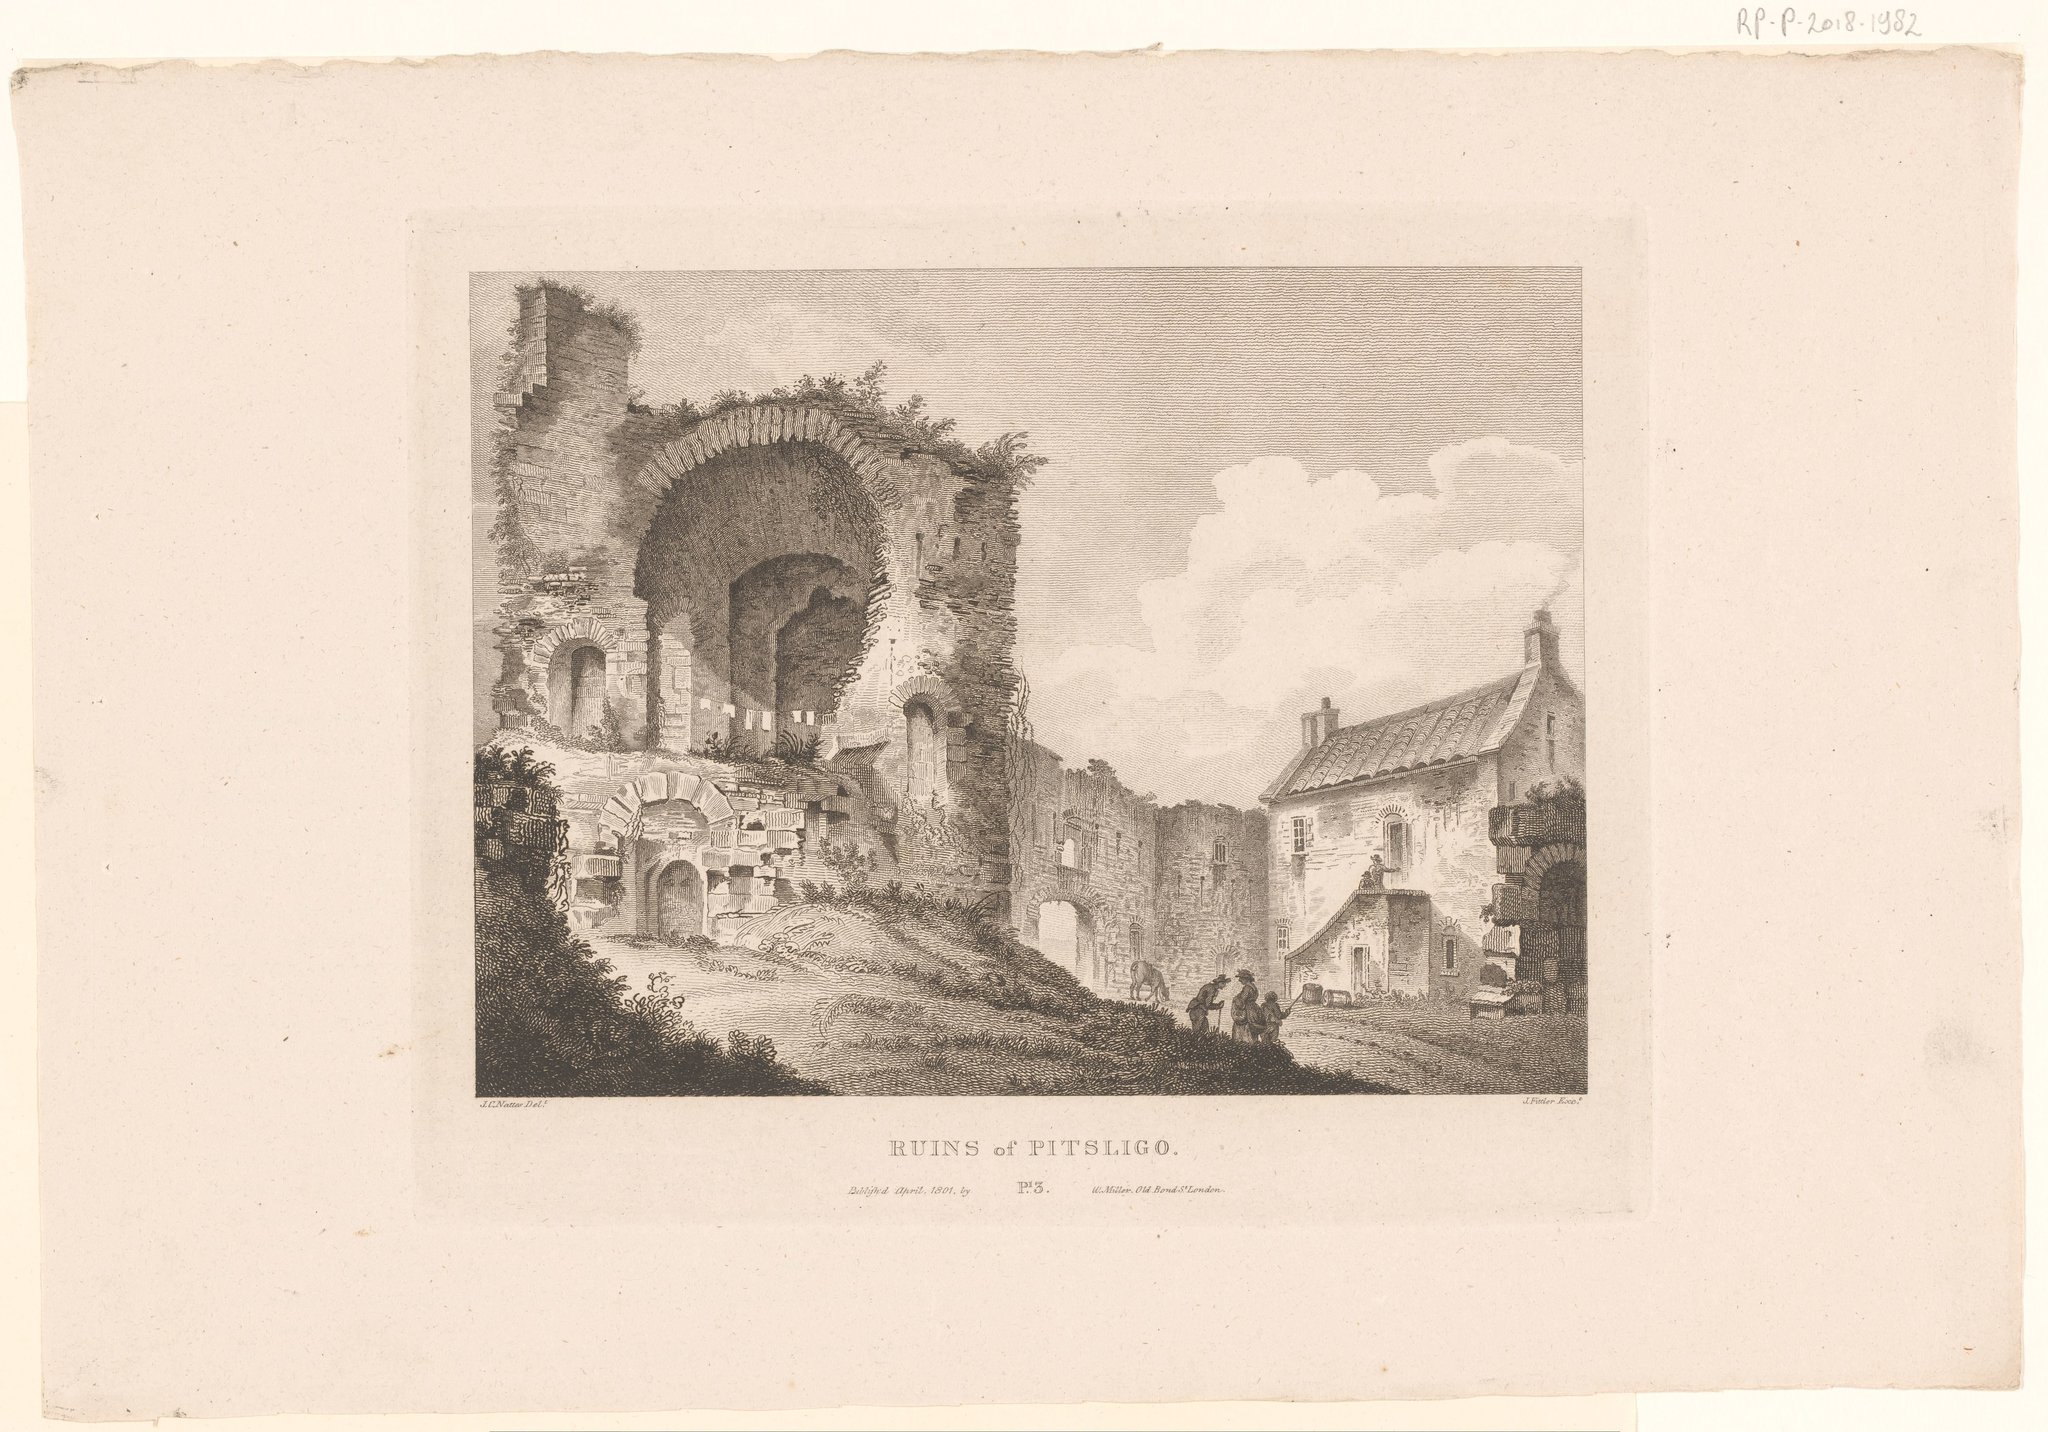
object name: print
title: Ruins of Pitsligo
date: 1801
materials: paper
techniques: engraving, etching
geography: london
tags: ruin of a dwelling, house, castle, etc.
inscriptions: collector's mark: Lugt 2228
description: Prent gebruikt in: Scotia Depicta; or the antiquities, castles, public buildings, noblemen (...). Londen: William Miller, 1801. Zie ook: RP-P-2018-1983.